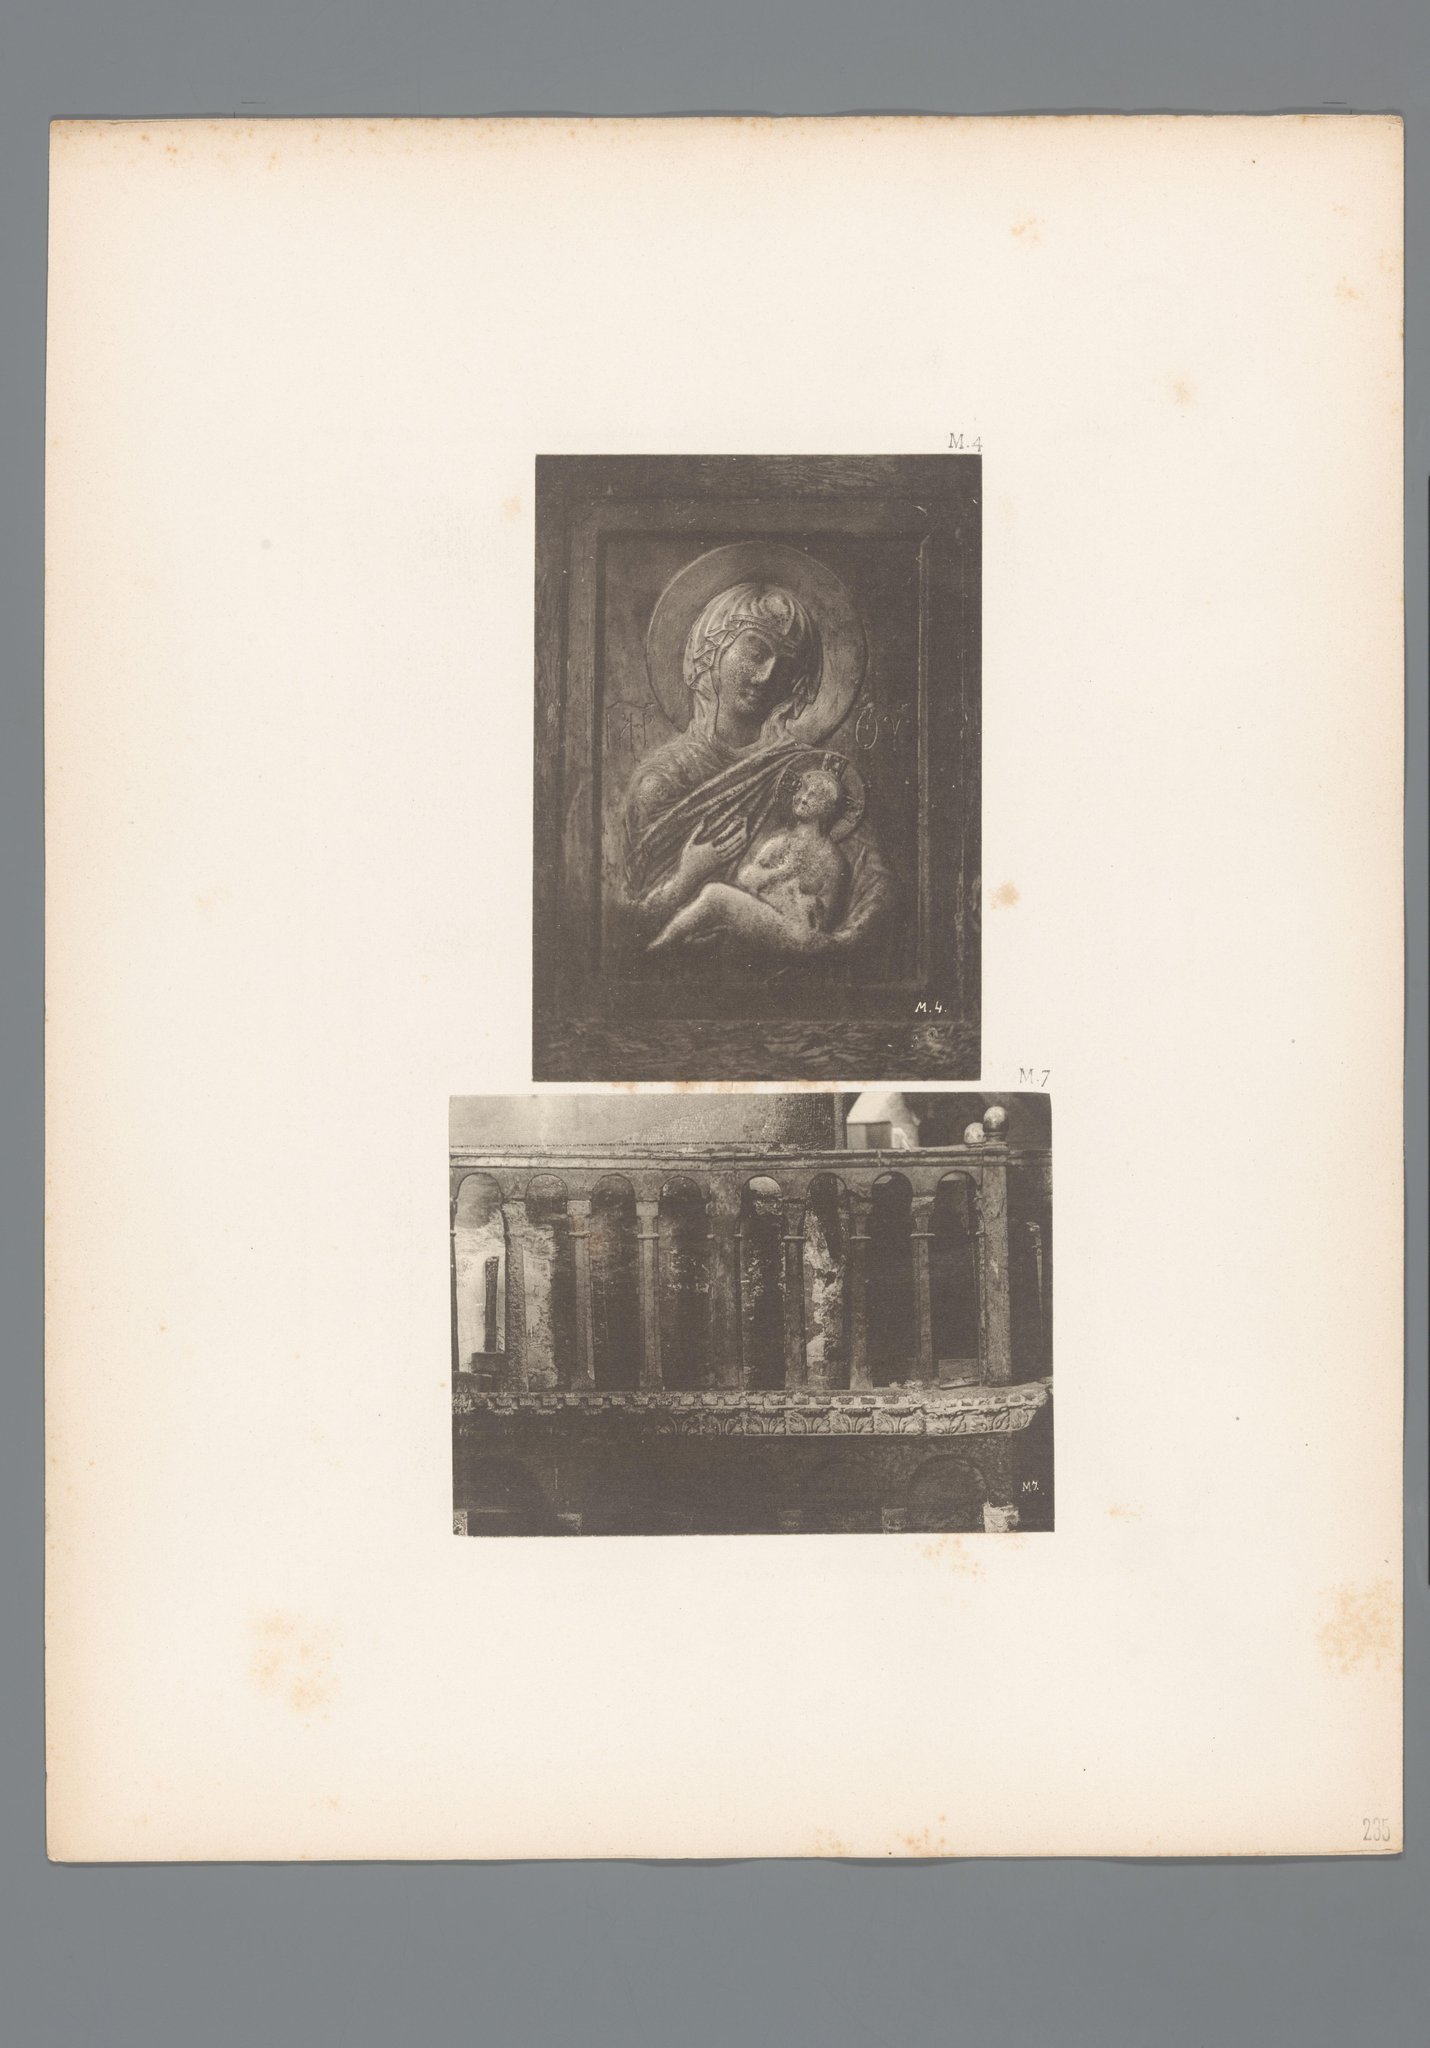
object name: photomechanical print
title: Reliëf van Maria met Christus en een detail van de San Marco in Venetië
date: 1880-1885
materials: paper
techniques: photograph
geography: venice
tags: mary standing (or half-length), the christ-child in front of her, close to her bosom, piece of sculpture, reproduction of a piece of sculpture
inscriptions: number: ‘235’, number: ‘M.7’, number: ‘M7.’, number: ‘M.4’, number: ‘M.4.’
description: Deze prenten maken deel uit van een omslag met 79 prenten op 53 bladen en 2 tekstbladen.